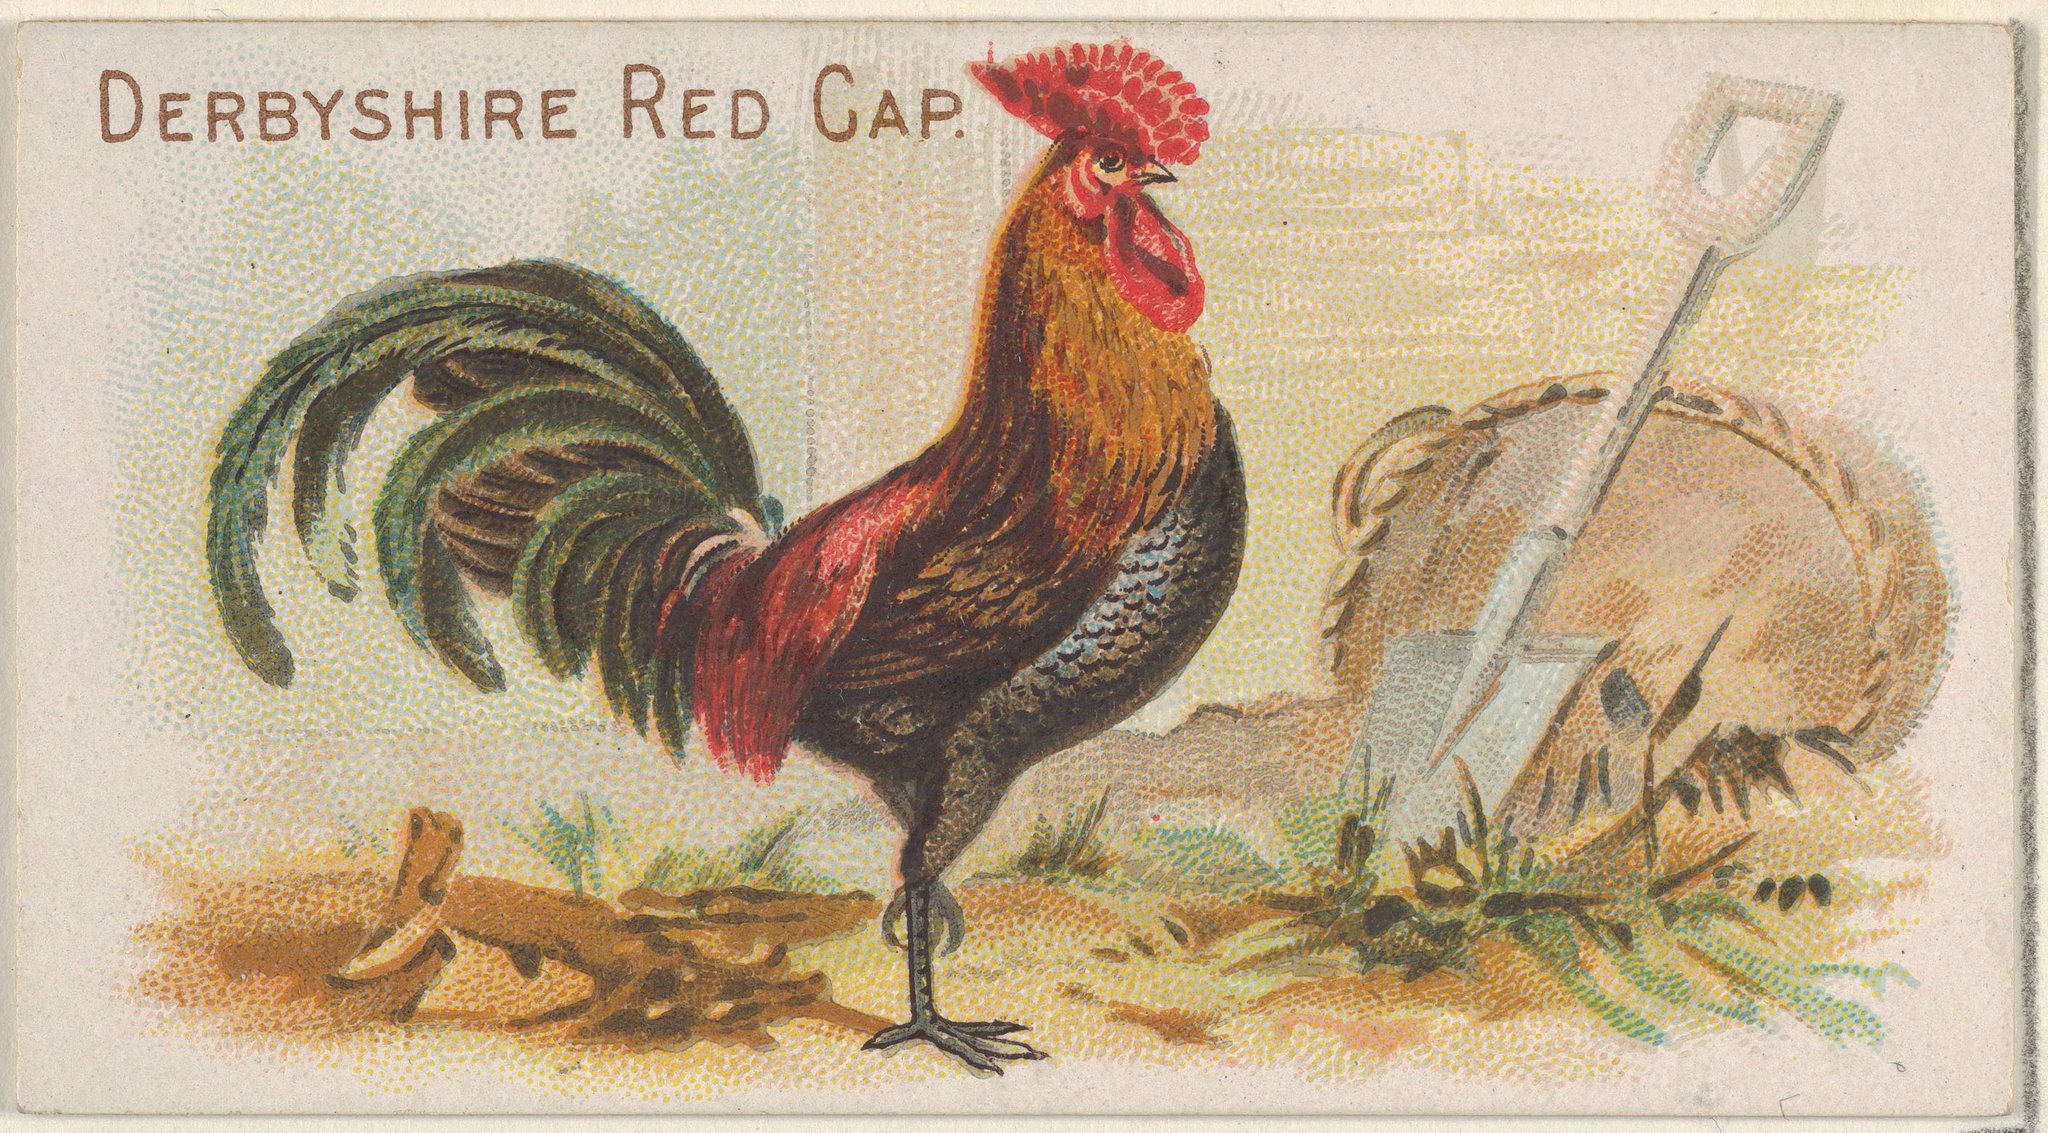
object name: print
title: Derbyshire Red Cap, from the Prize and Game Chickens series (N20) for Allen & Ginter Cigarettes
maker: allen & ginter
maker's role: publisher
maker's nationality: american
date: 1891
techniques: color lithograph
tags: chickens